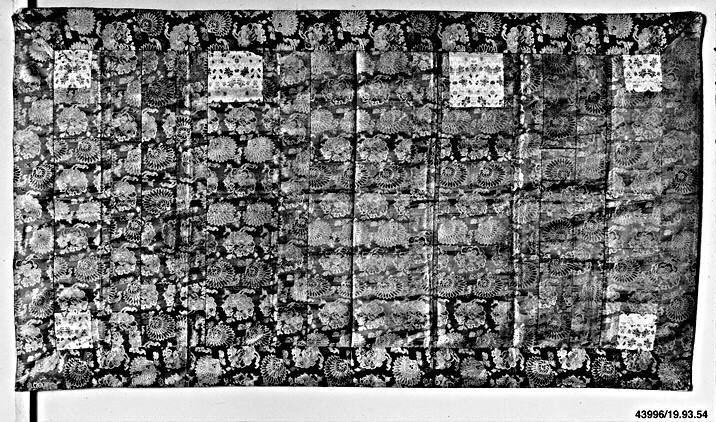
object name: robe, priest's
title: Priest's Robe (Shichijō)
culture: japanese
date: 1573-1592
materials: silk